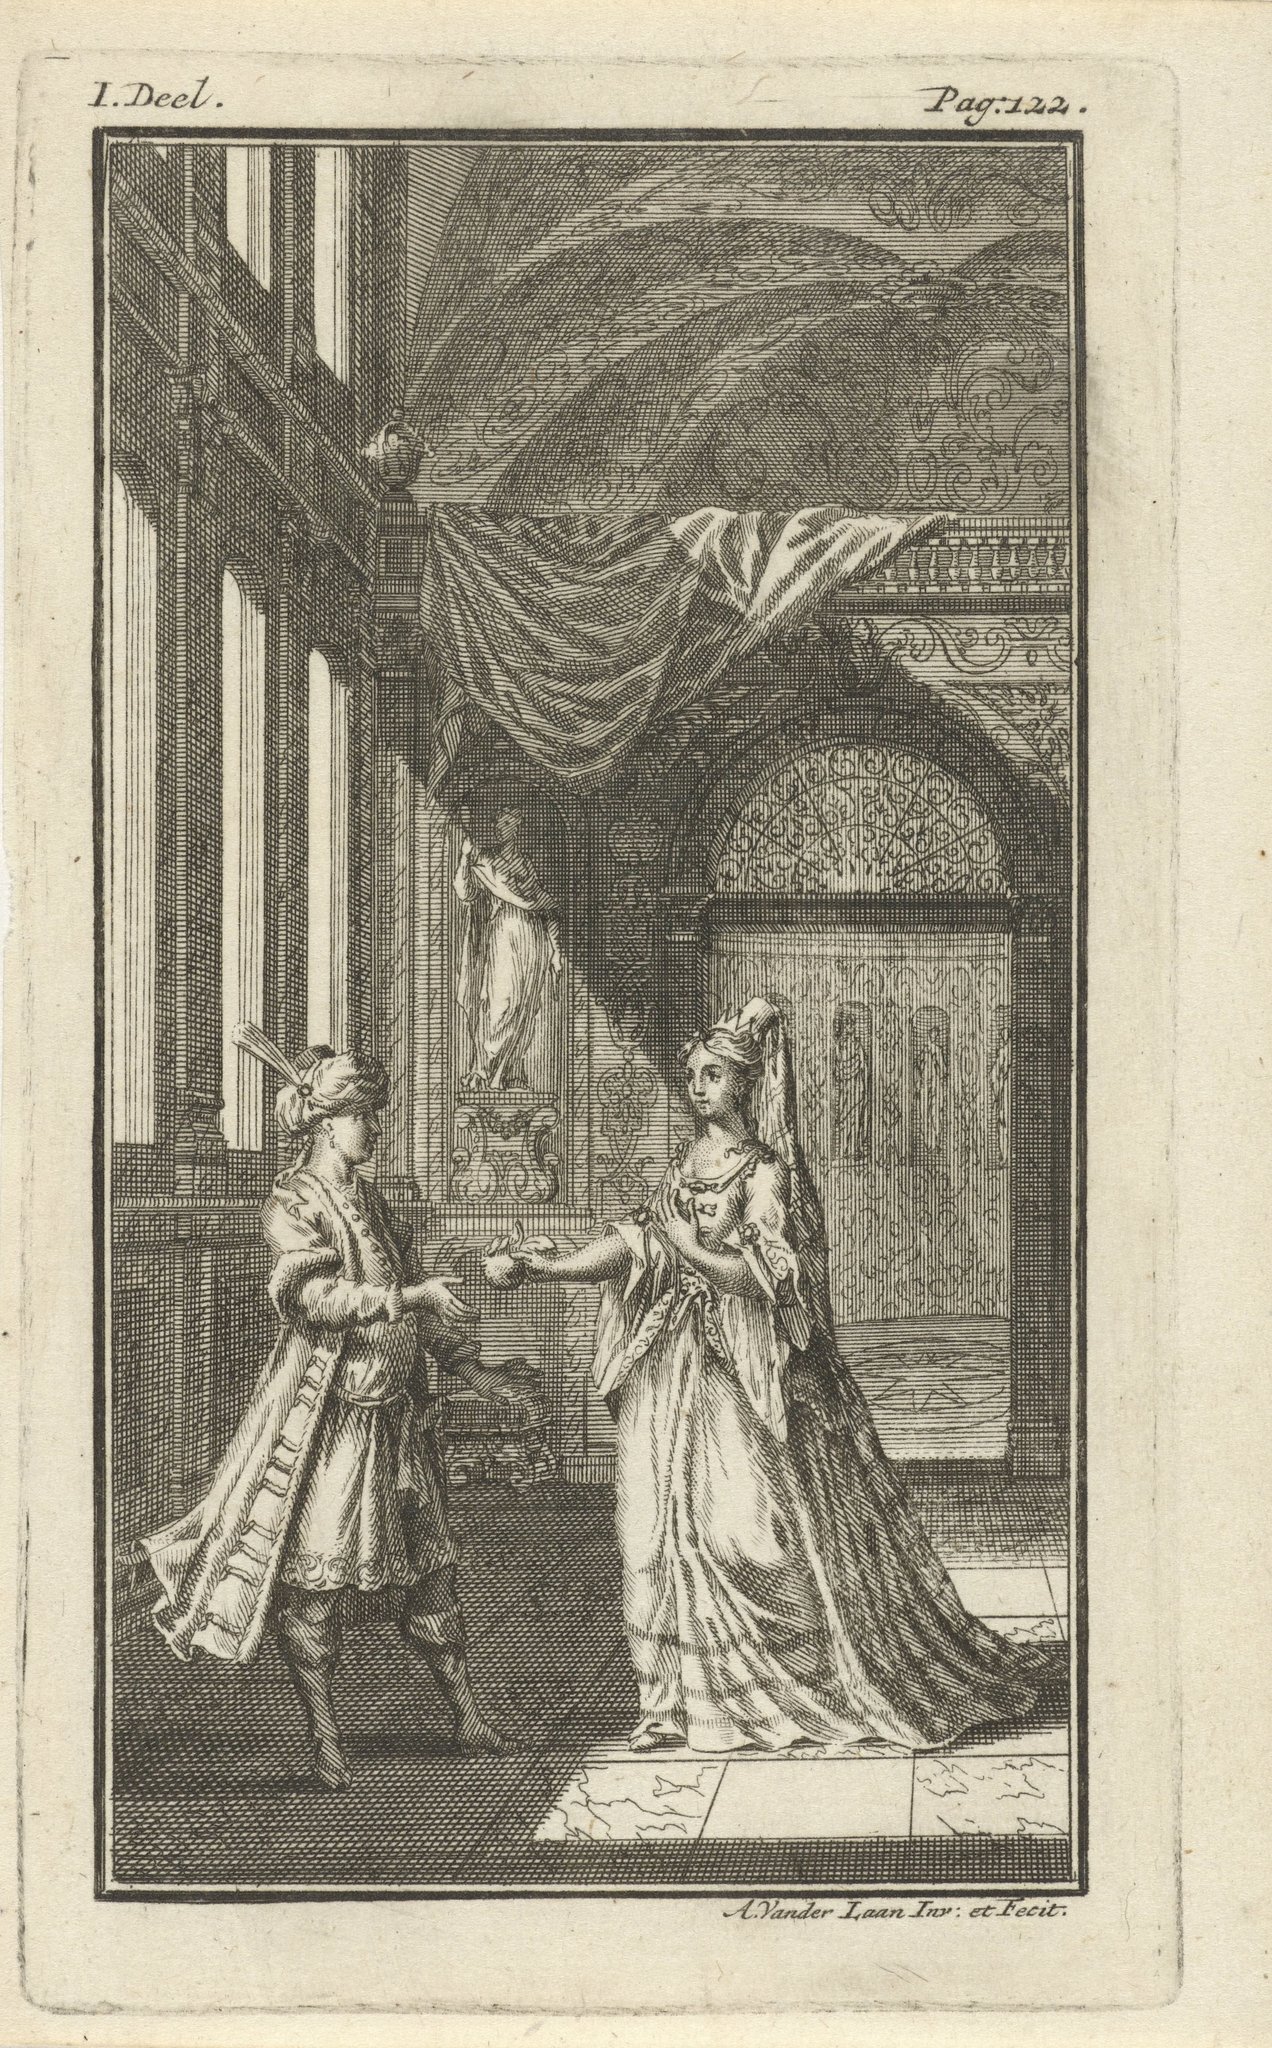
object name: print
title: Keizerin en dienaar in een vertrek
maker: adolf van der laan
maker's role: draughtsman, print maker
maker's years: 1689-1742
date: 1730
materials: paper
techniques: etching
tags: ruler and his subjects - bb - female ruler, palace - aa - civic architecture: inside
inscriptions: collector's mark: Lugt 2228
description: Illustratie vervaardigd voor de herdruk van het treurspel "Eudochia, keyzerinne te Konstantinopelen" in Roeland van Leuve's "Mengelwerken", uitgegeven te Amsterdam door Gerrit Bouman, 1730.